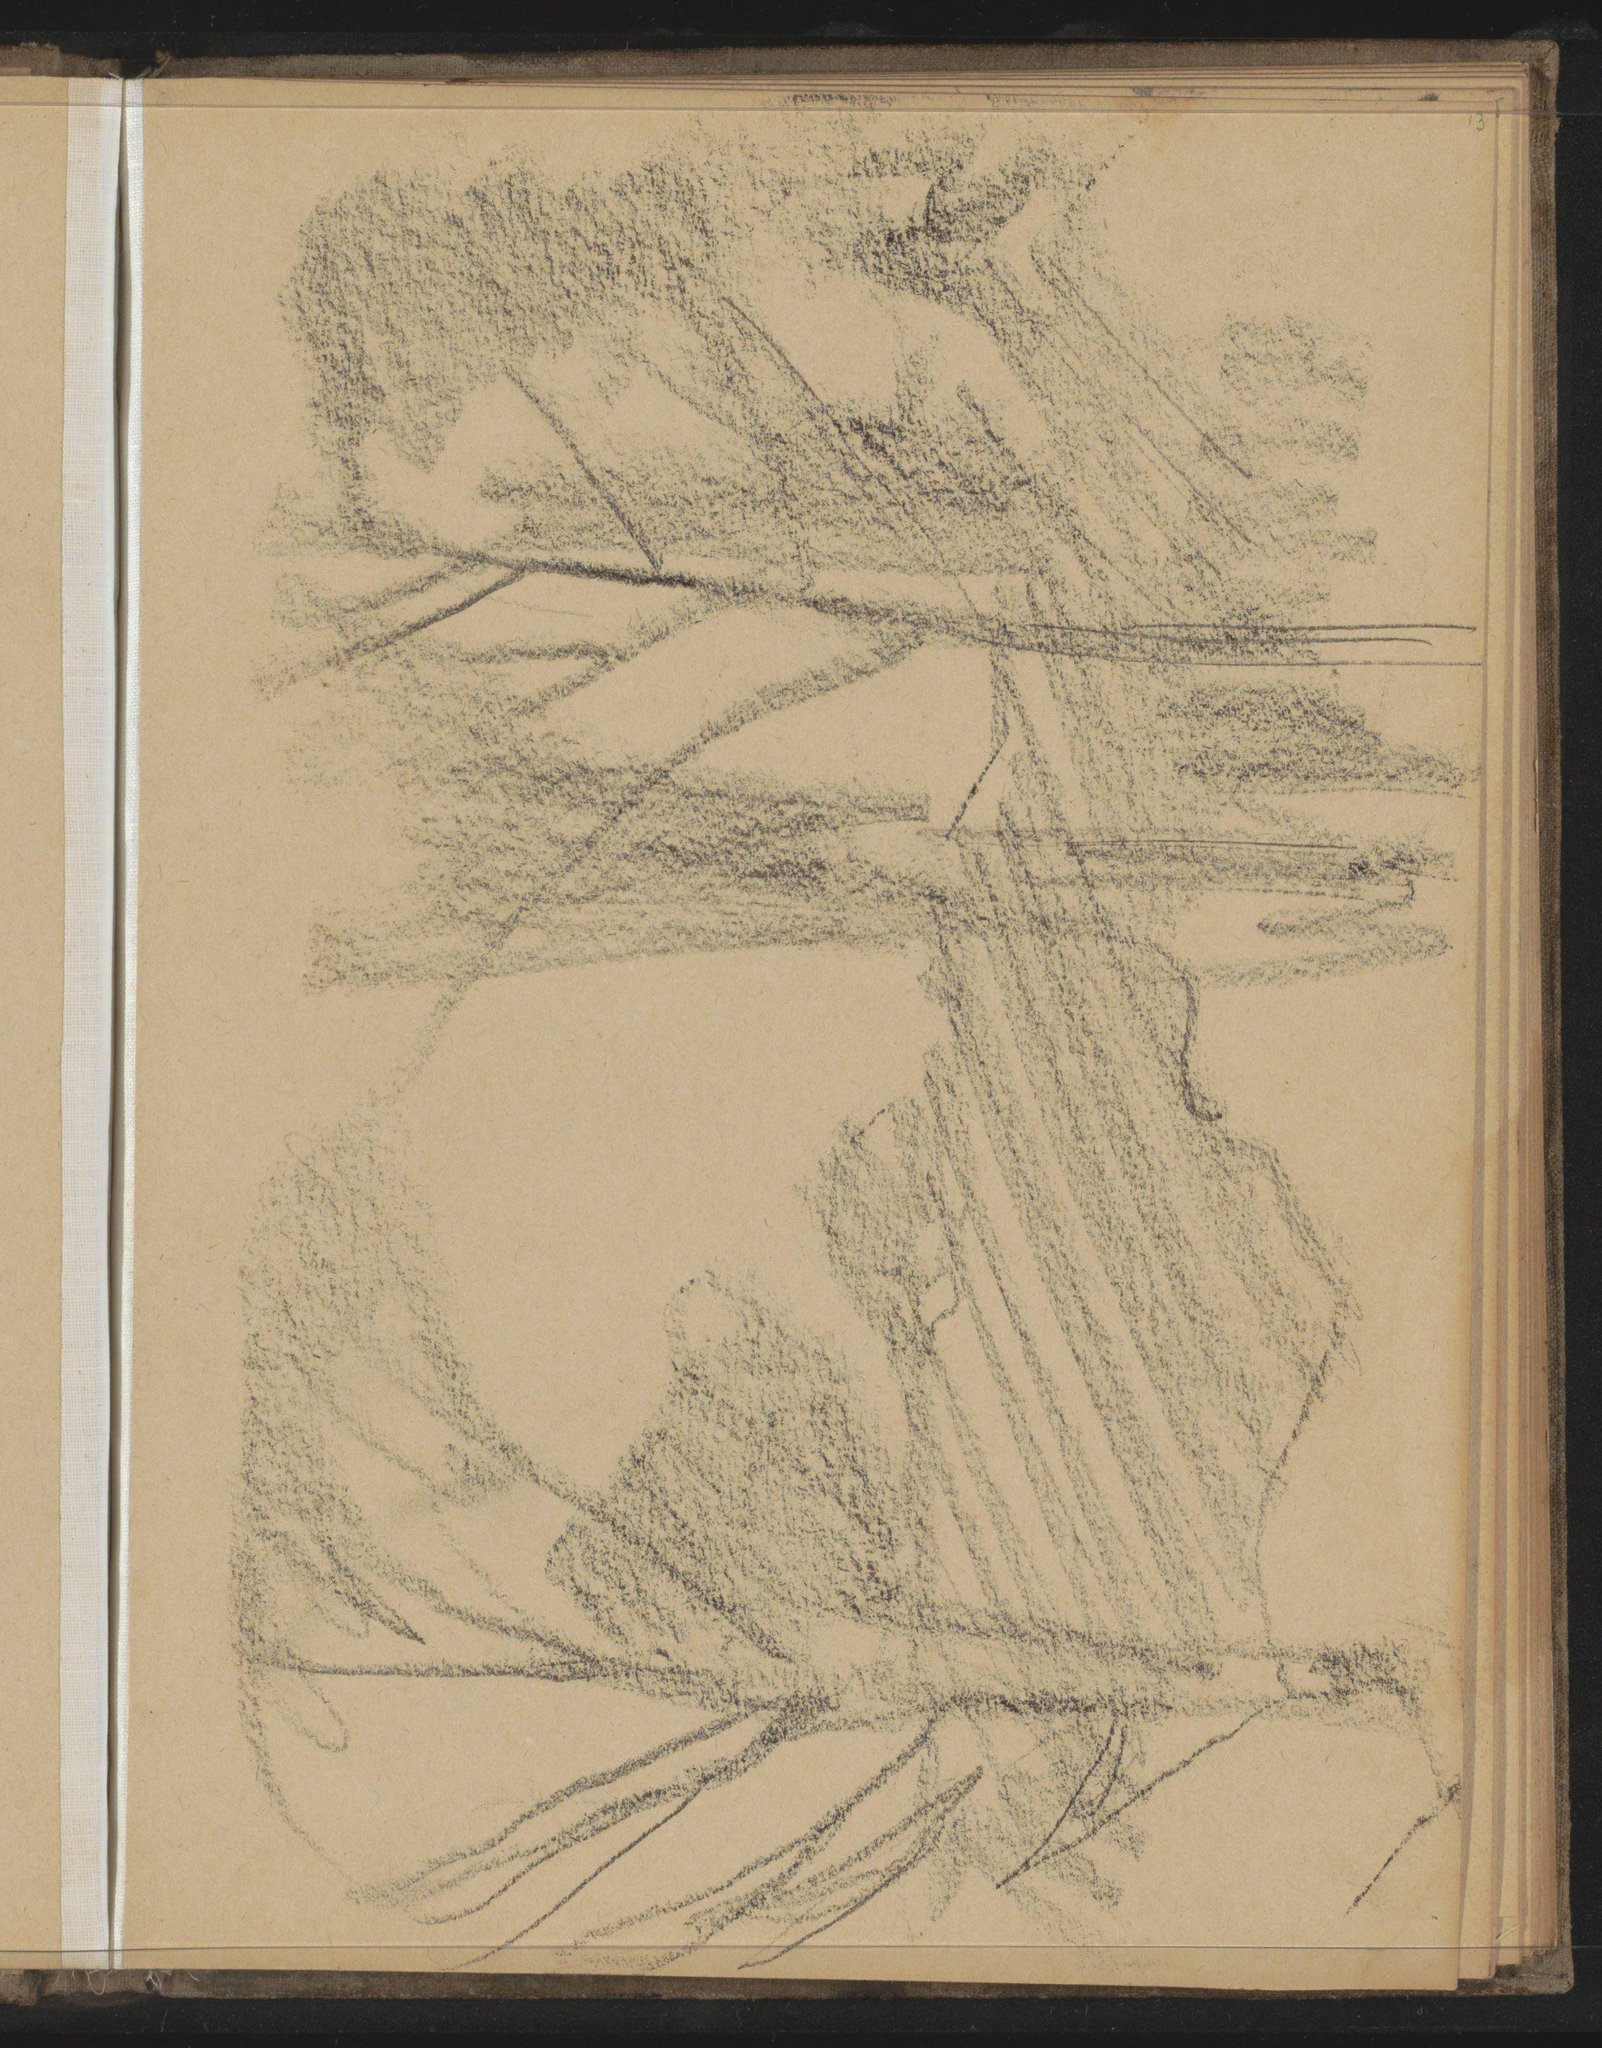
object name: sketchbook leaf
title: Landschap met bomen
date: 1892-1897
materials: chalk, paper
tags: trees, landscapes in the temperate zone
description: Pagina 13 uit een schetsboek met 24 bladen.